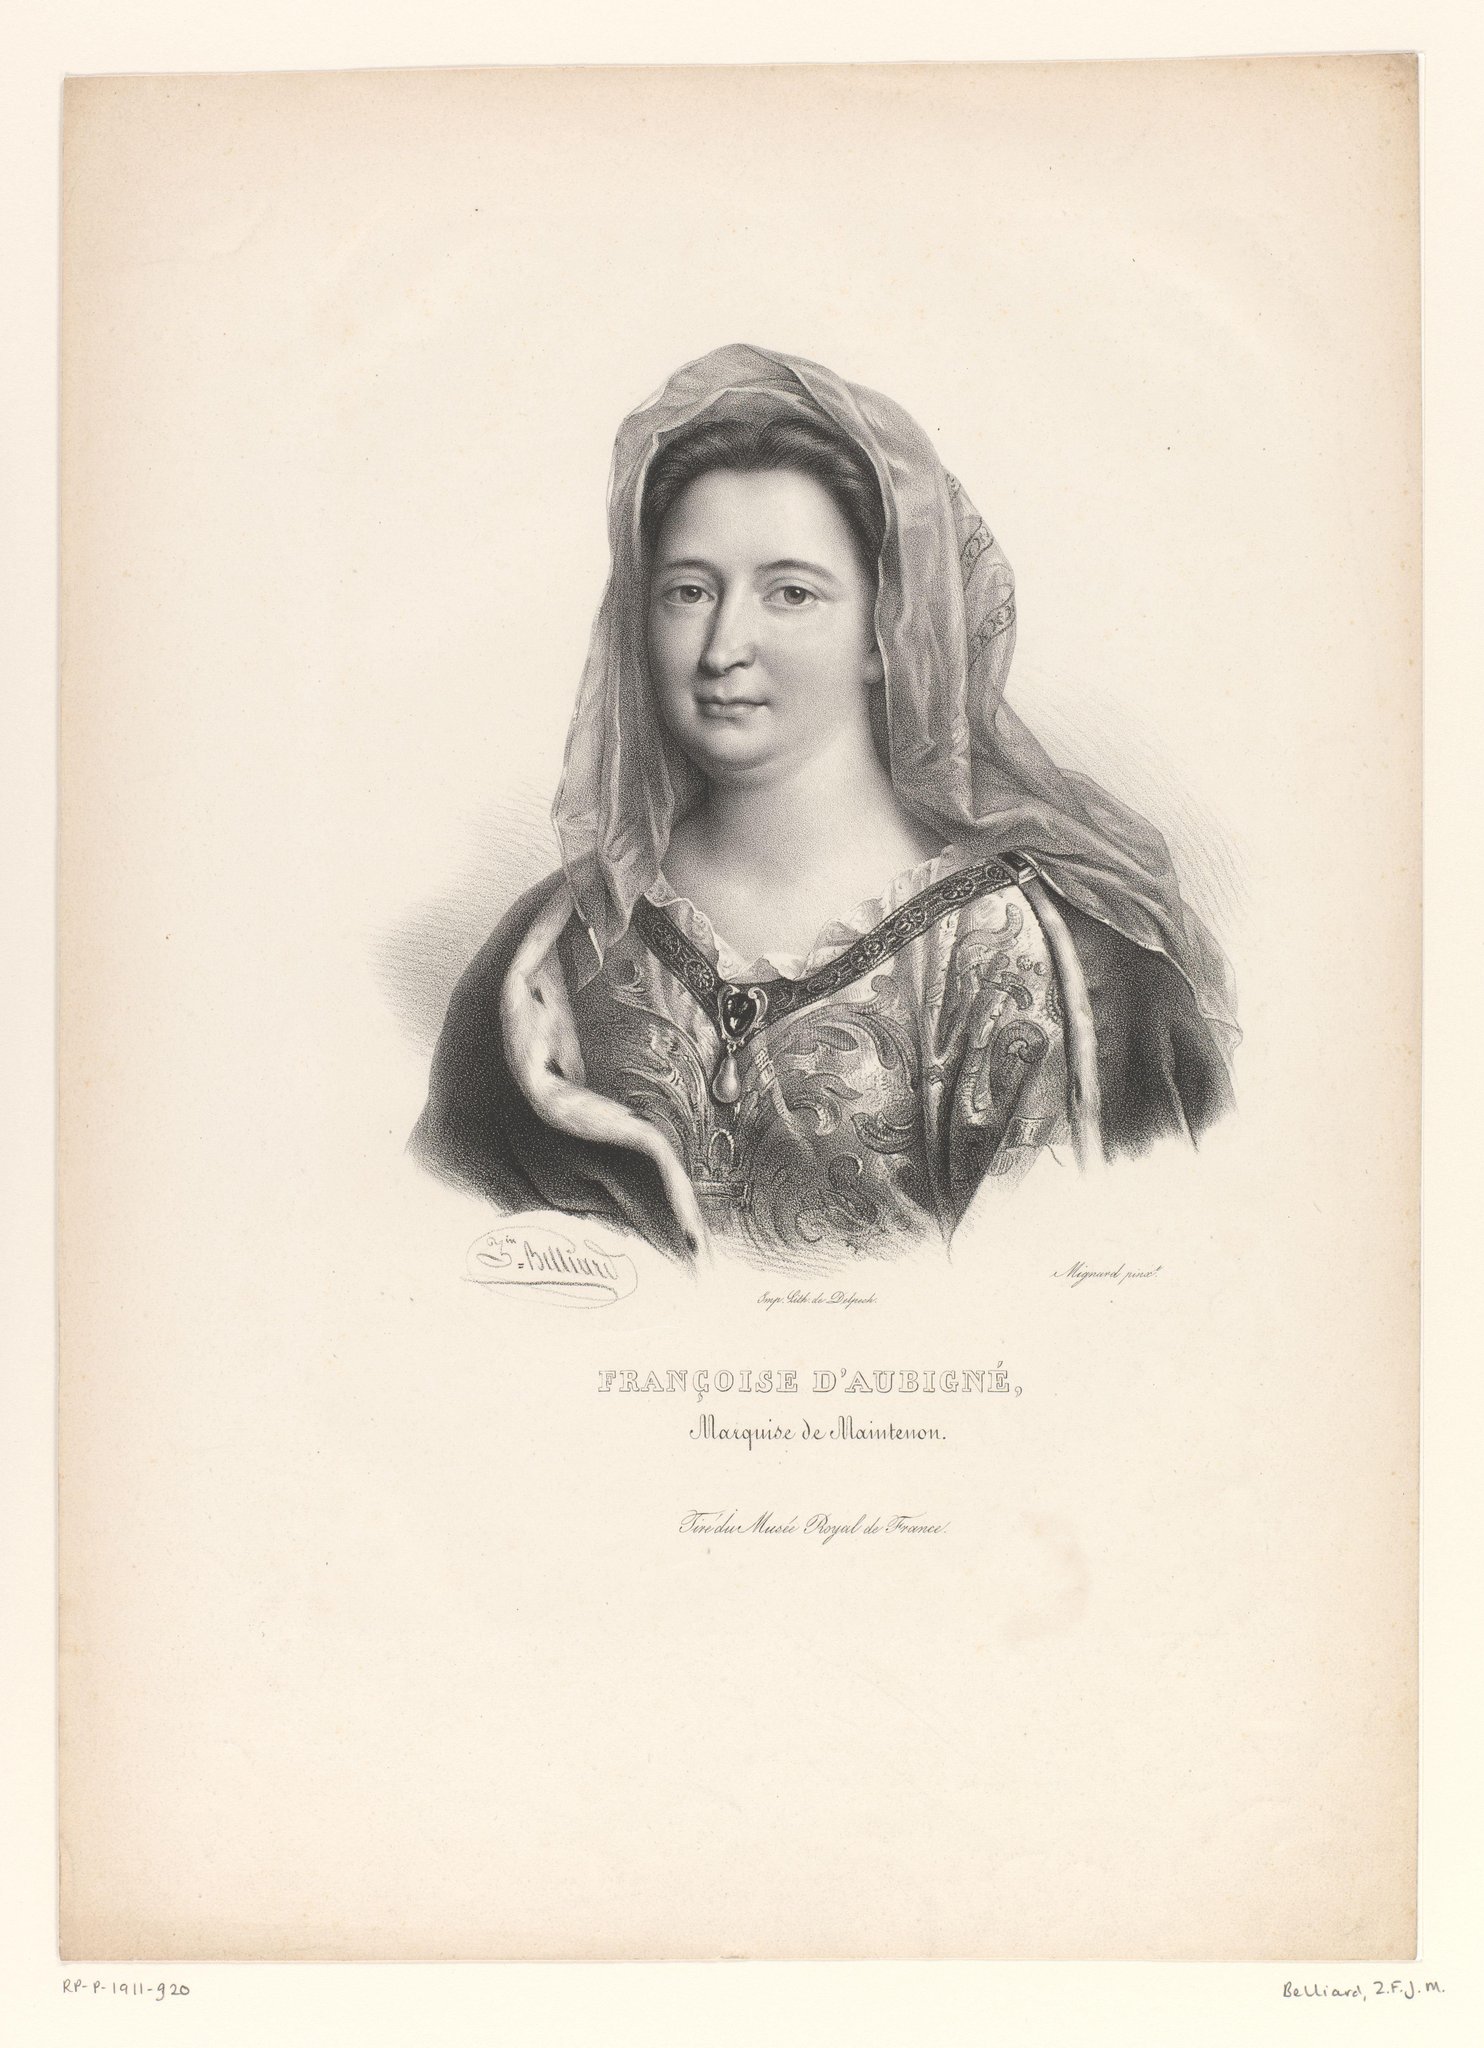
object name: book illustration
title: Portret van Madame de Maintenon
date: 1829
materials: paper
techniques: lithograph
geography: paris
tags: madame de maintenon, historical persons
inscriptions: collector's mark: Lugt 2228a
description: Prent gepubliceerd in: Iconographie française, ou Choix de deux cents portraits d'hommes et de femmes depuis le règne de Charles VII jusqu'à la fin de celui de Louis XVI, publié par Madame Delpech, Parijs 1840.